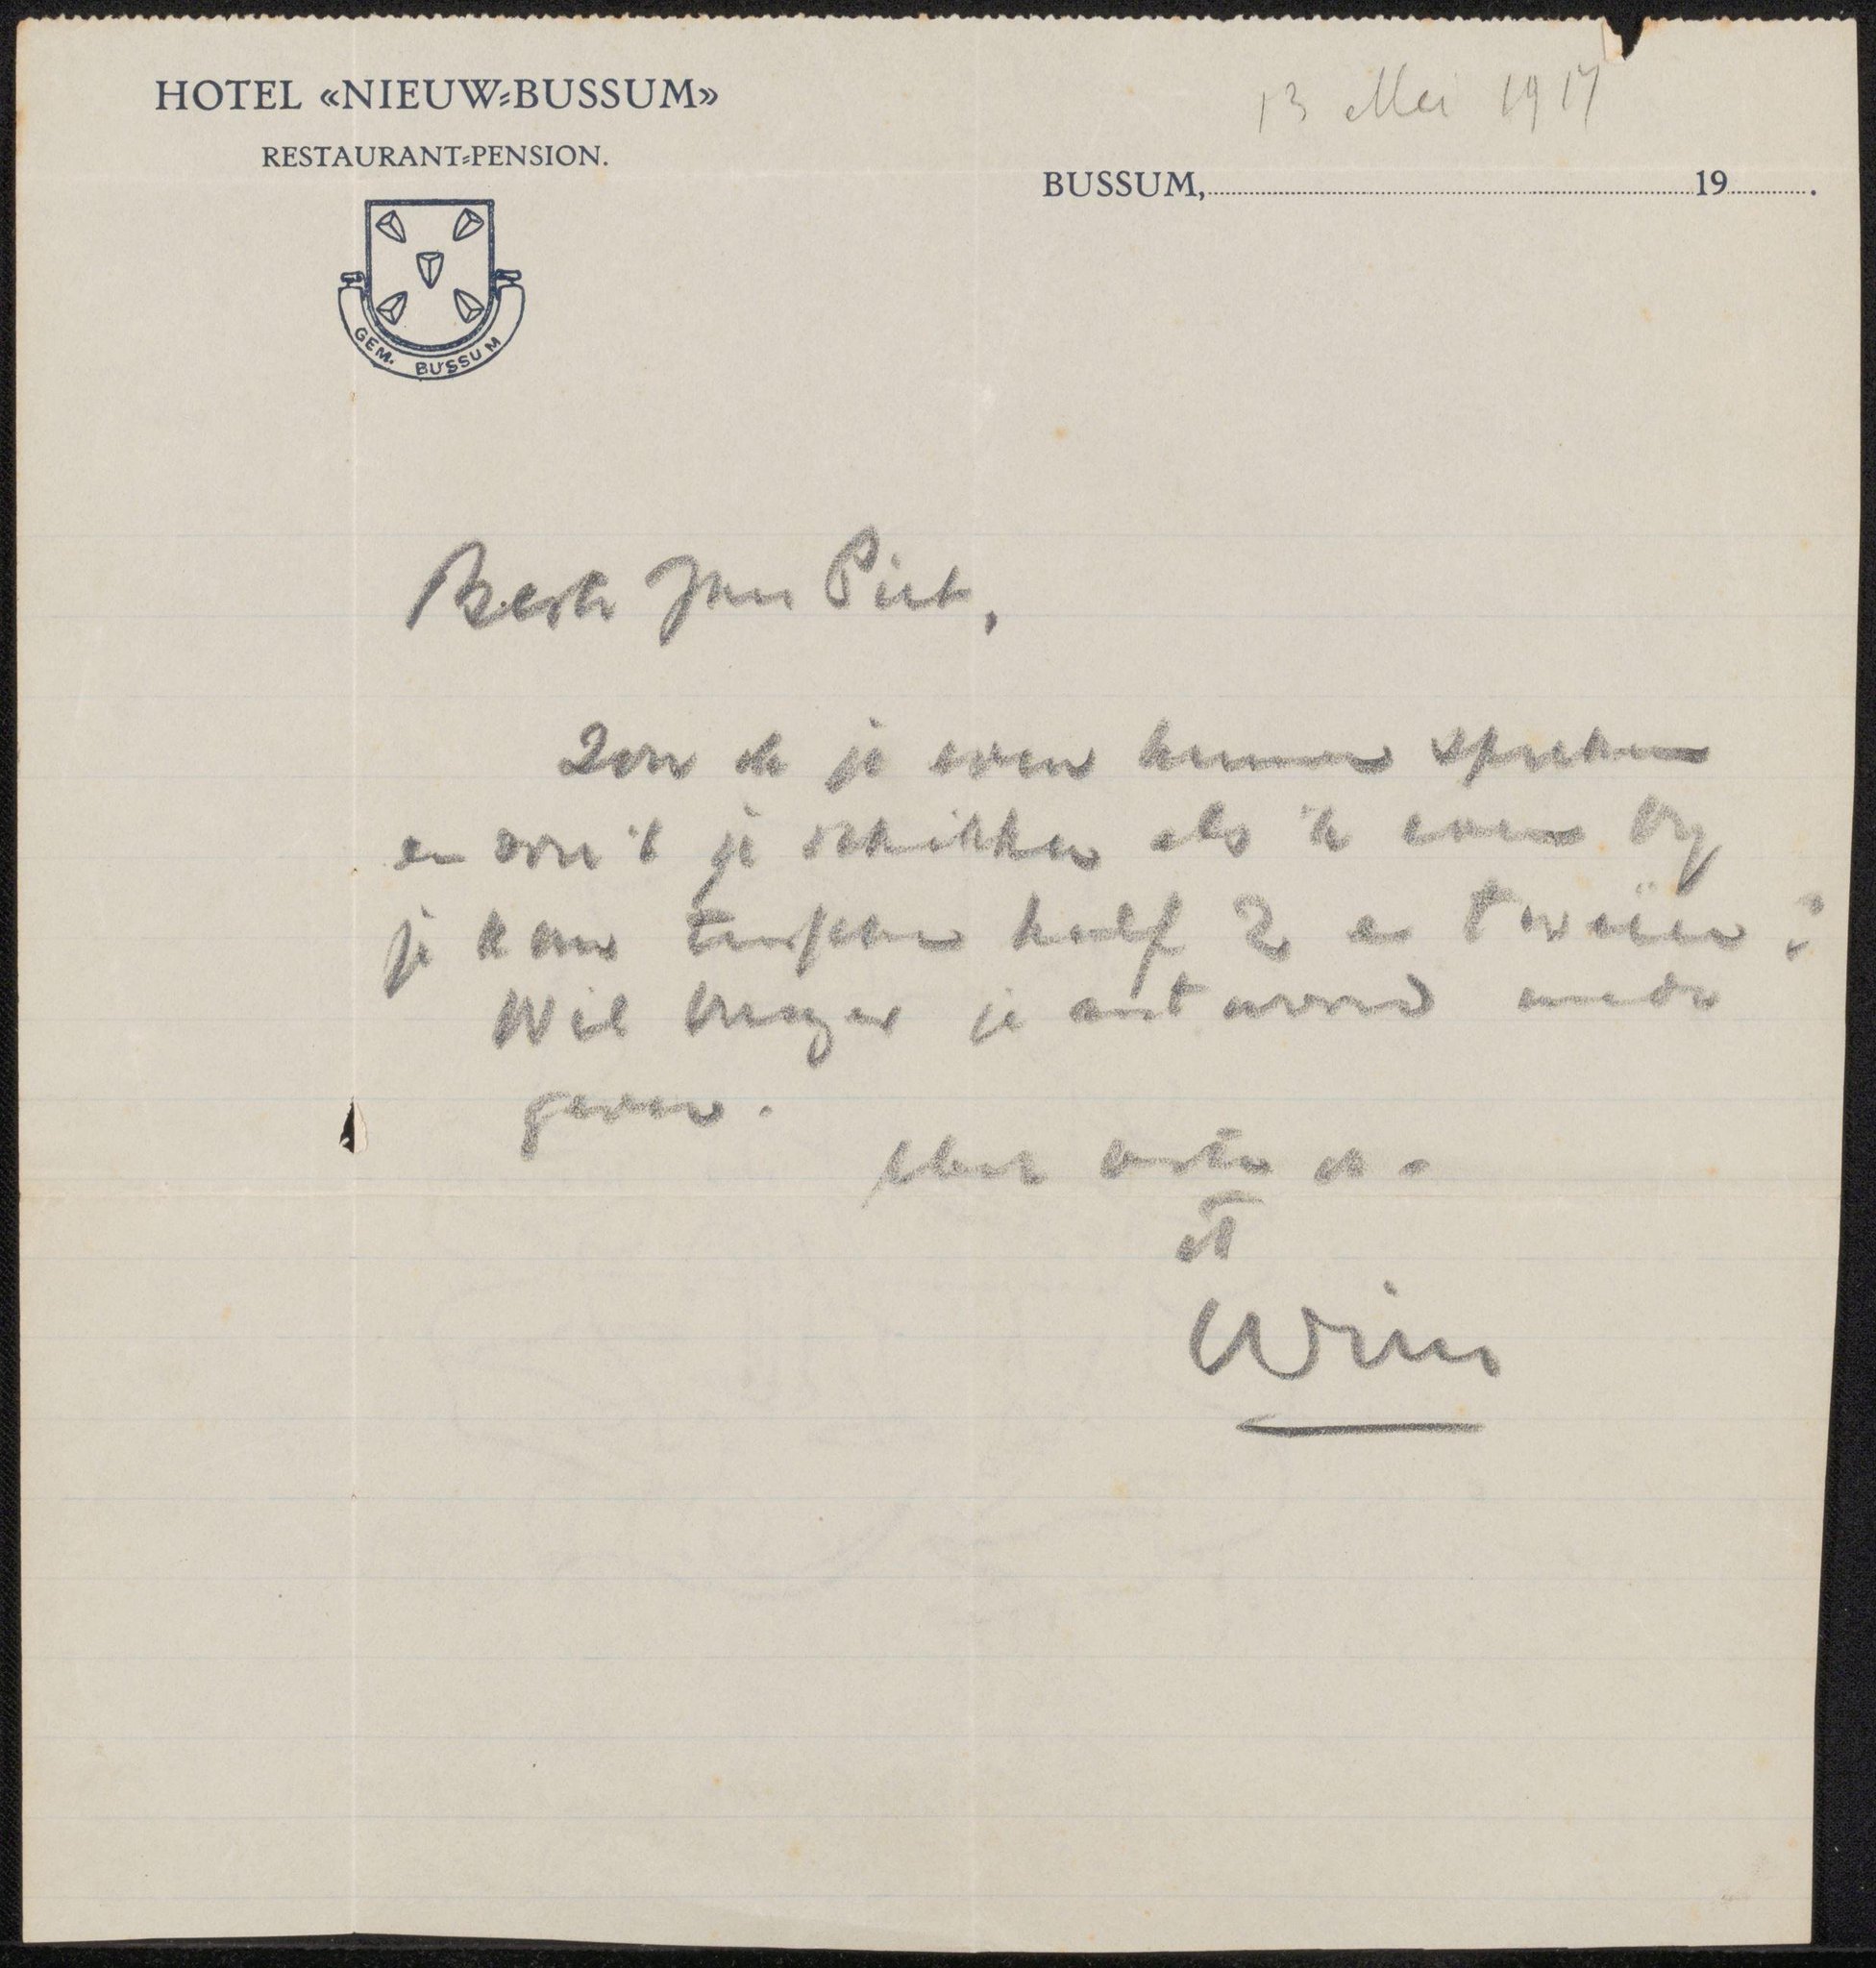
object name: letter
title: Brief aan Jan Veth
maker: willem witsen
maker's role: draughtsman, painter, print maker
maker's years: 1860-1923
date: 1874-1923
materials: pencil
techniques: printing, writing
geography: bussum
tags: painter, print maker, draughtsman, designer, jan veth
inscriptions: collector's mark: ‘RPK’, watermark